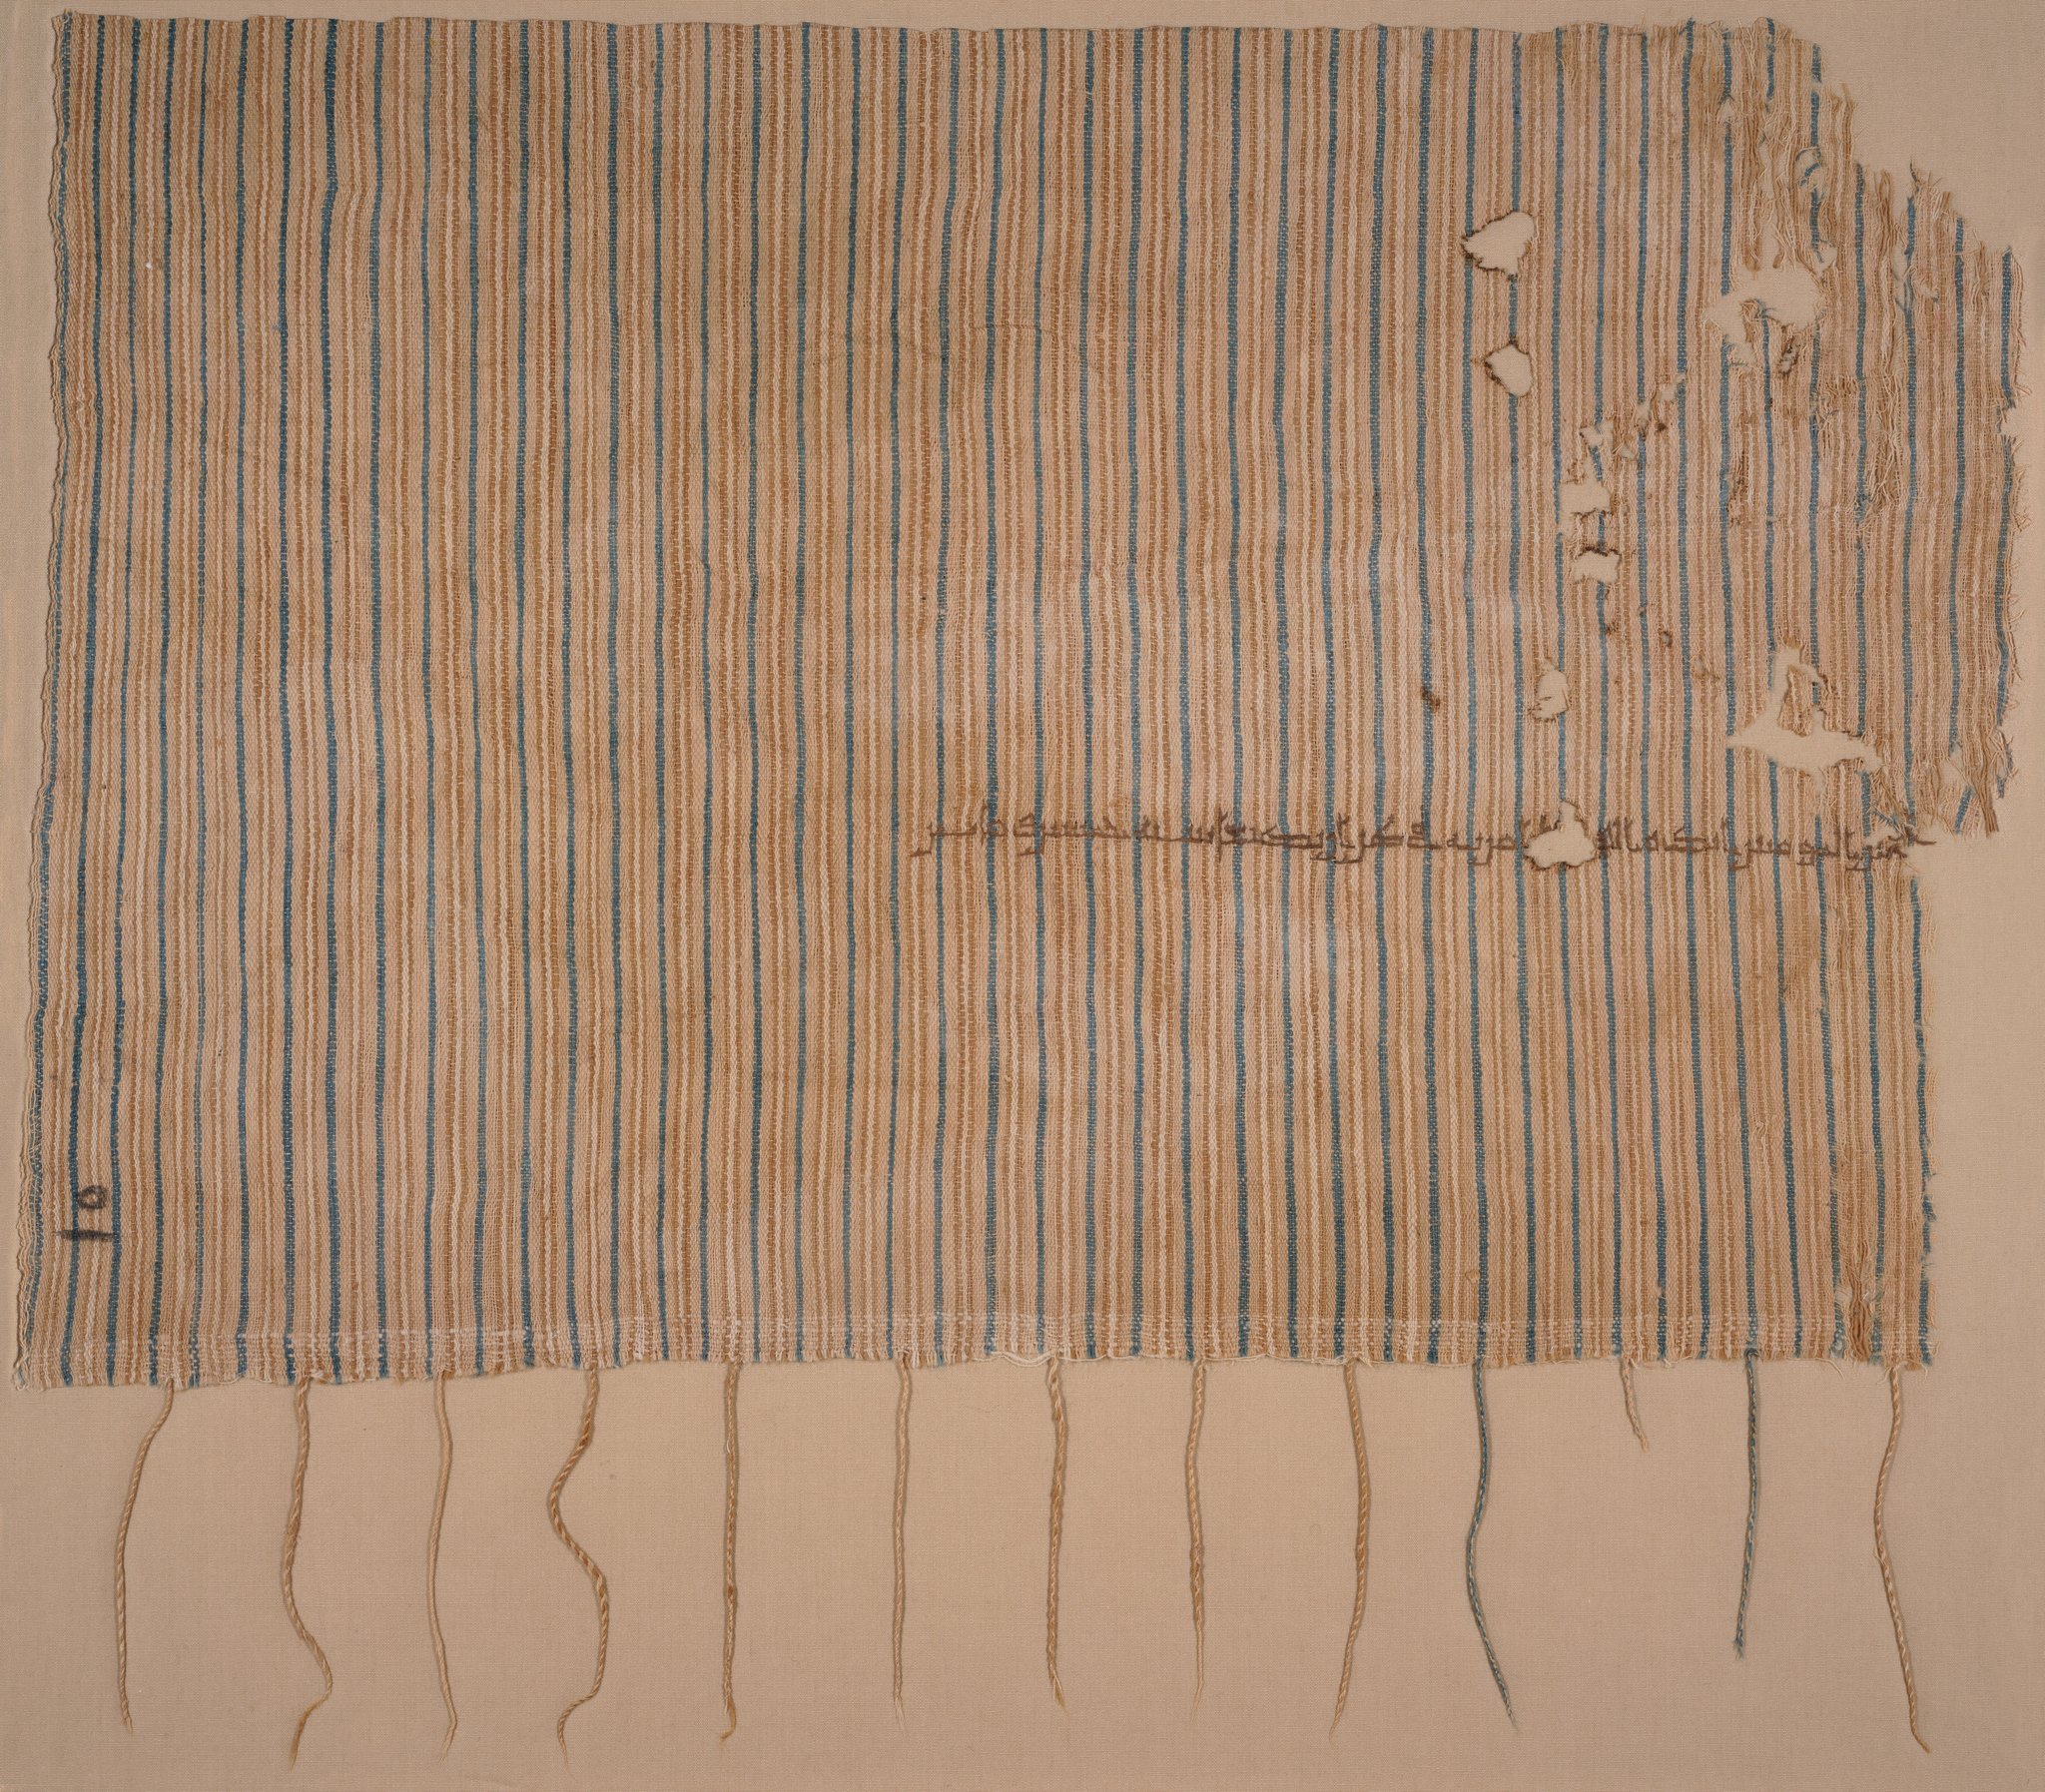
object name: textile fragment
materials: cotton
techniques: embroidery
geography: yemen